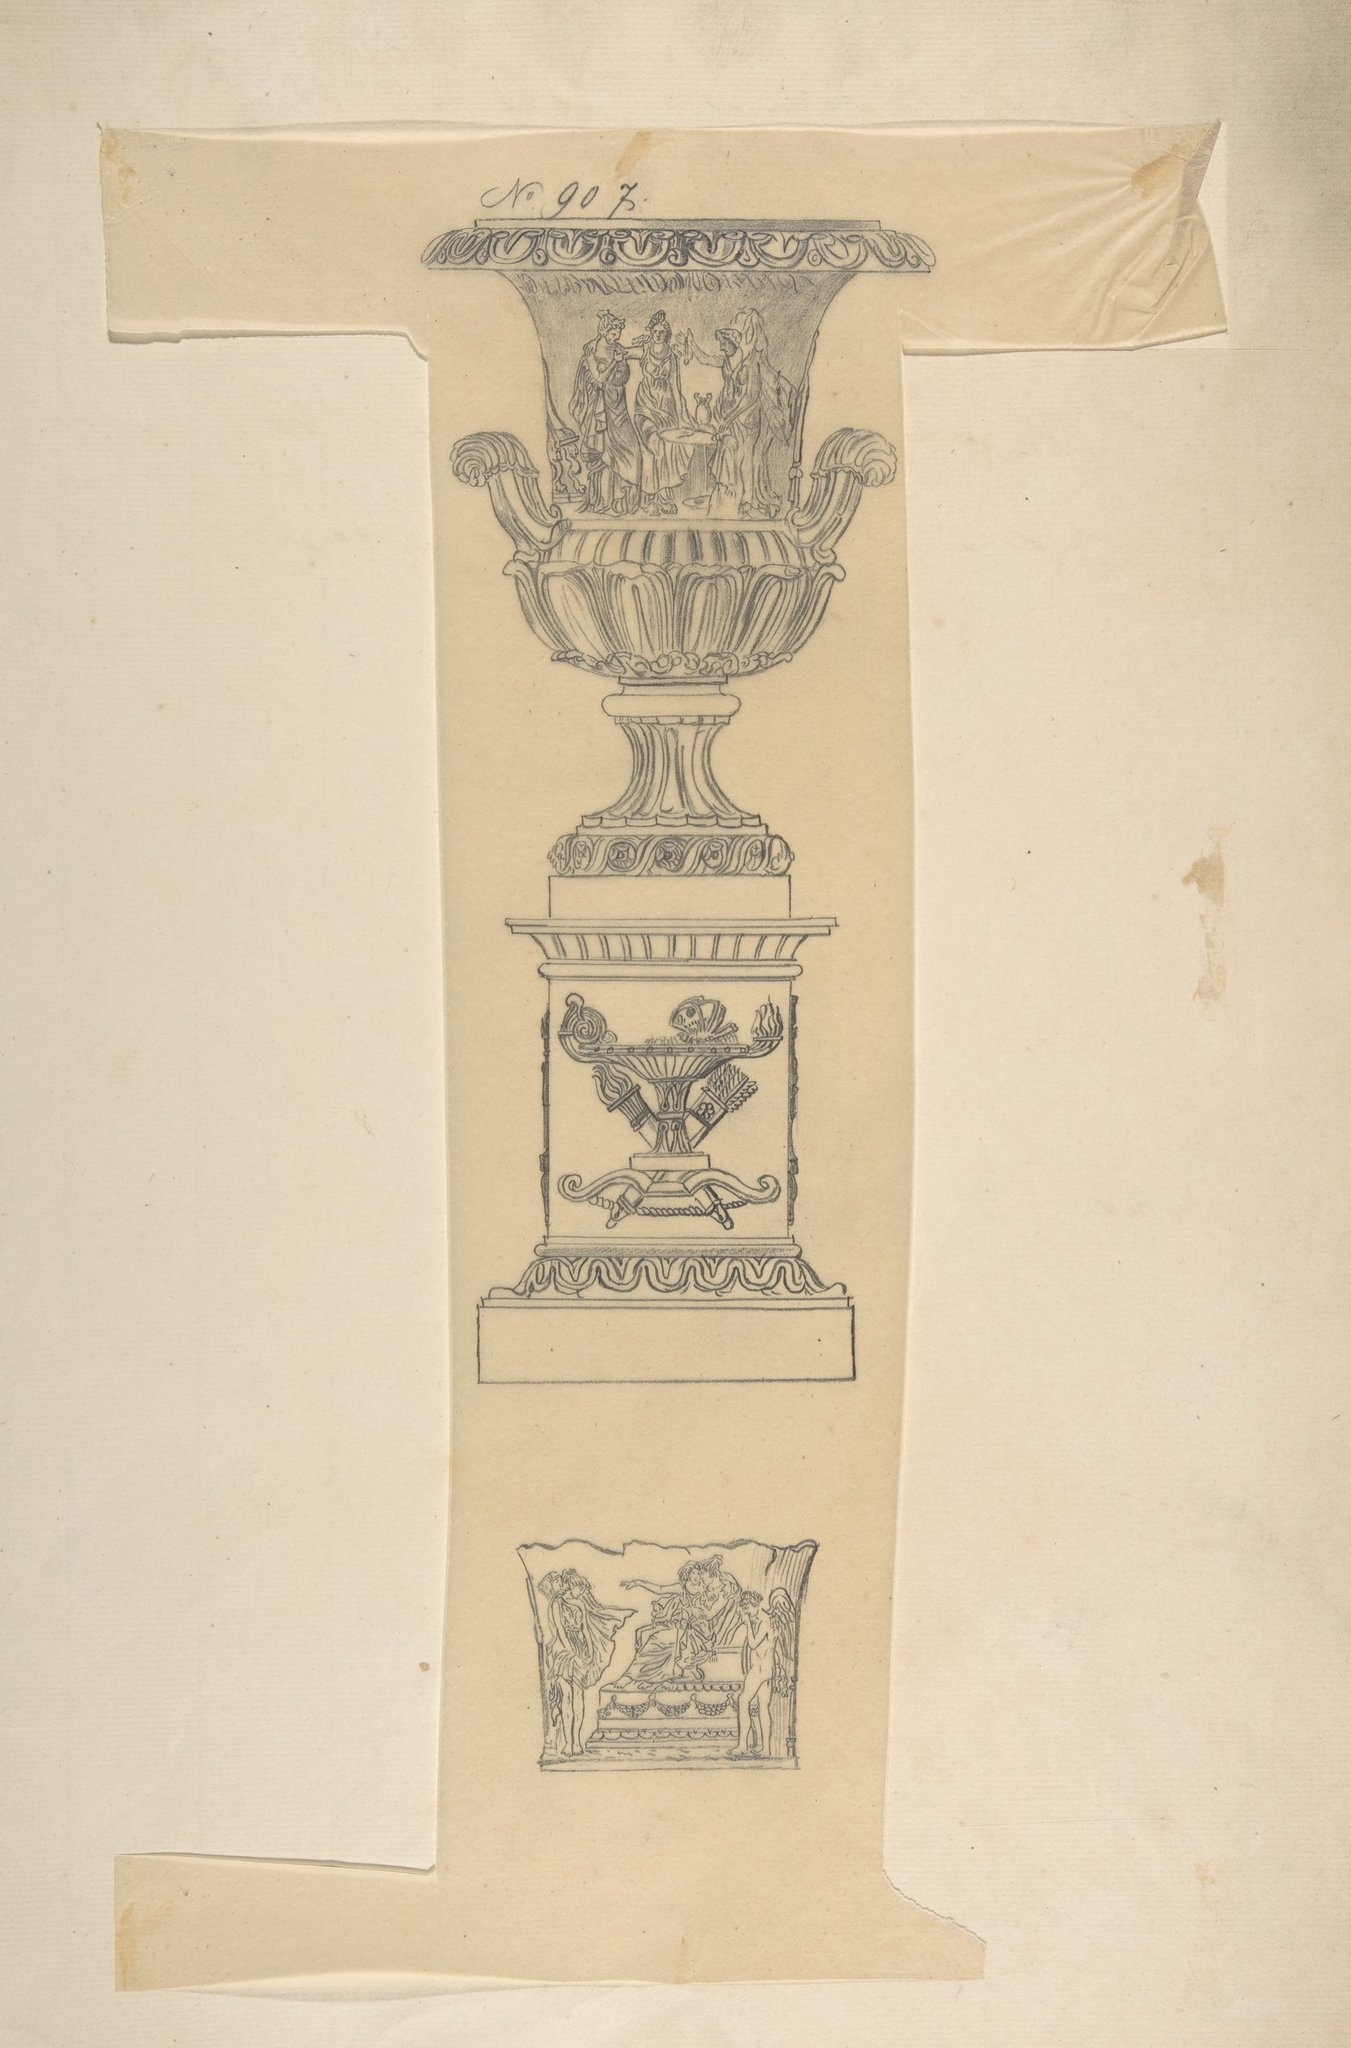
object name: drawing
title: Designs for an Urn on a Pedestal and a Cachepot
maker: anonymous, french, 19th century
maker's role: artist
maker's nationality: french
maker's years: 1800-1900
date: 1801-1900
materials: graphite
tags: bow and arrow,women,urns